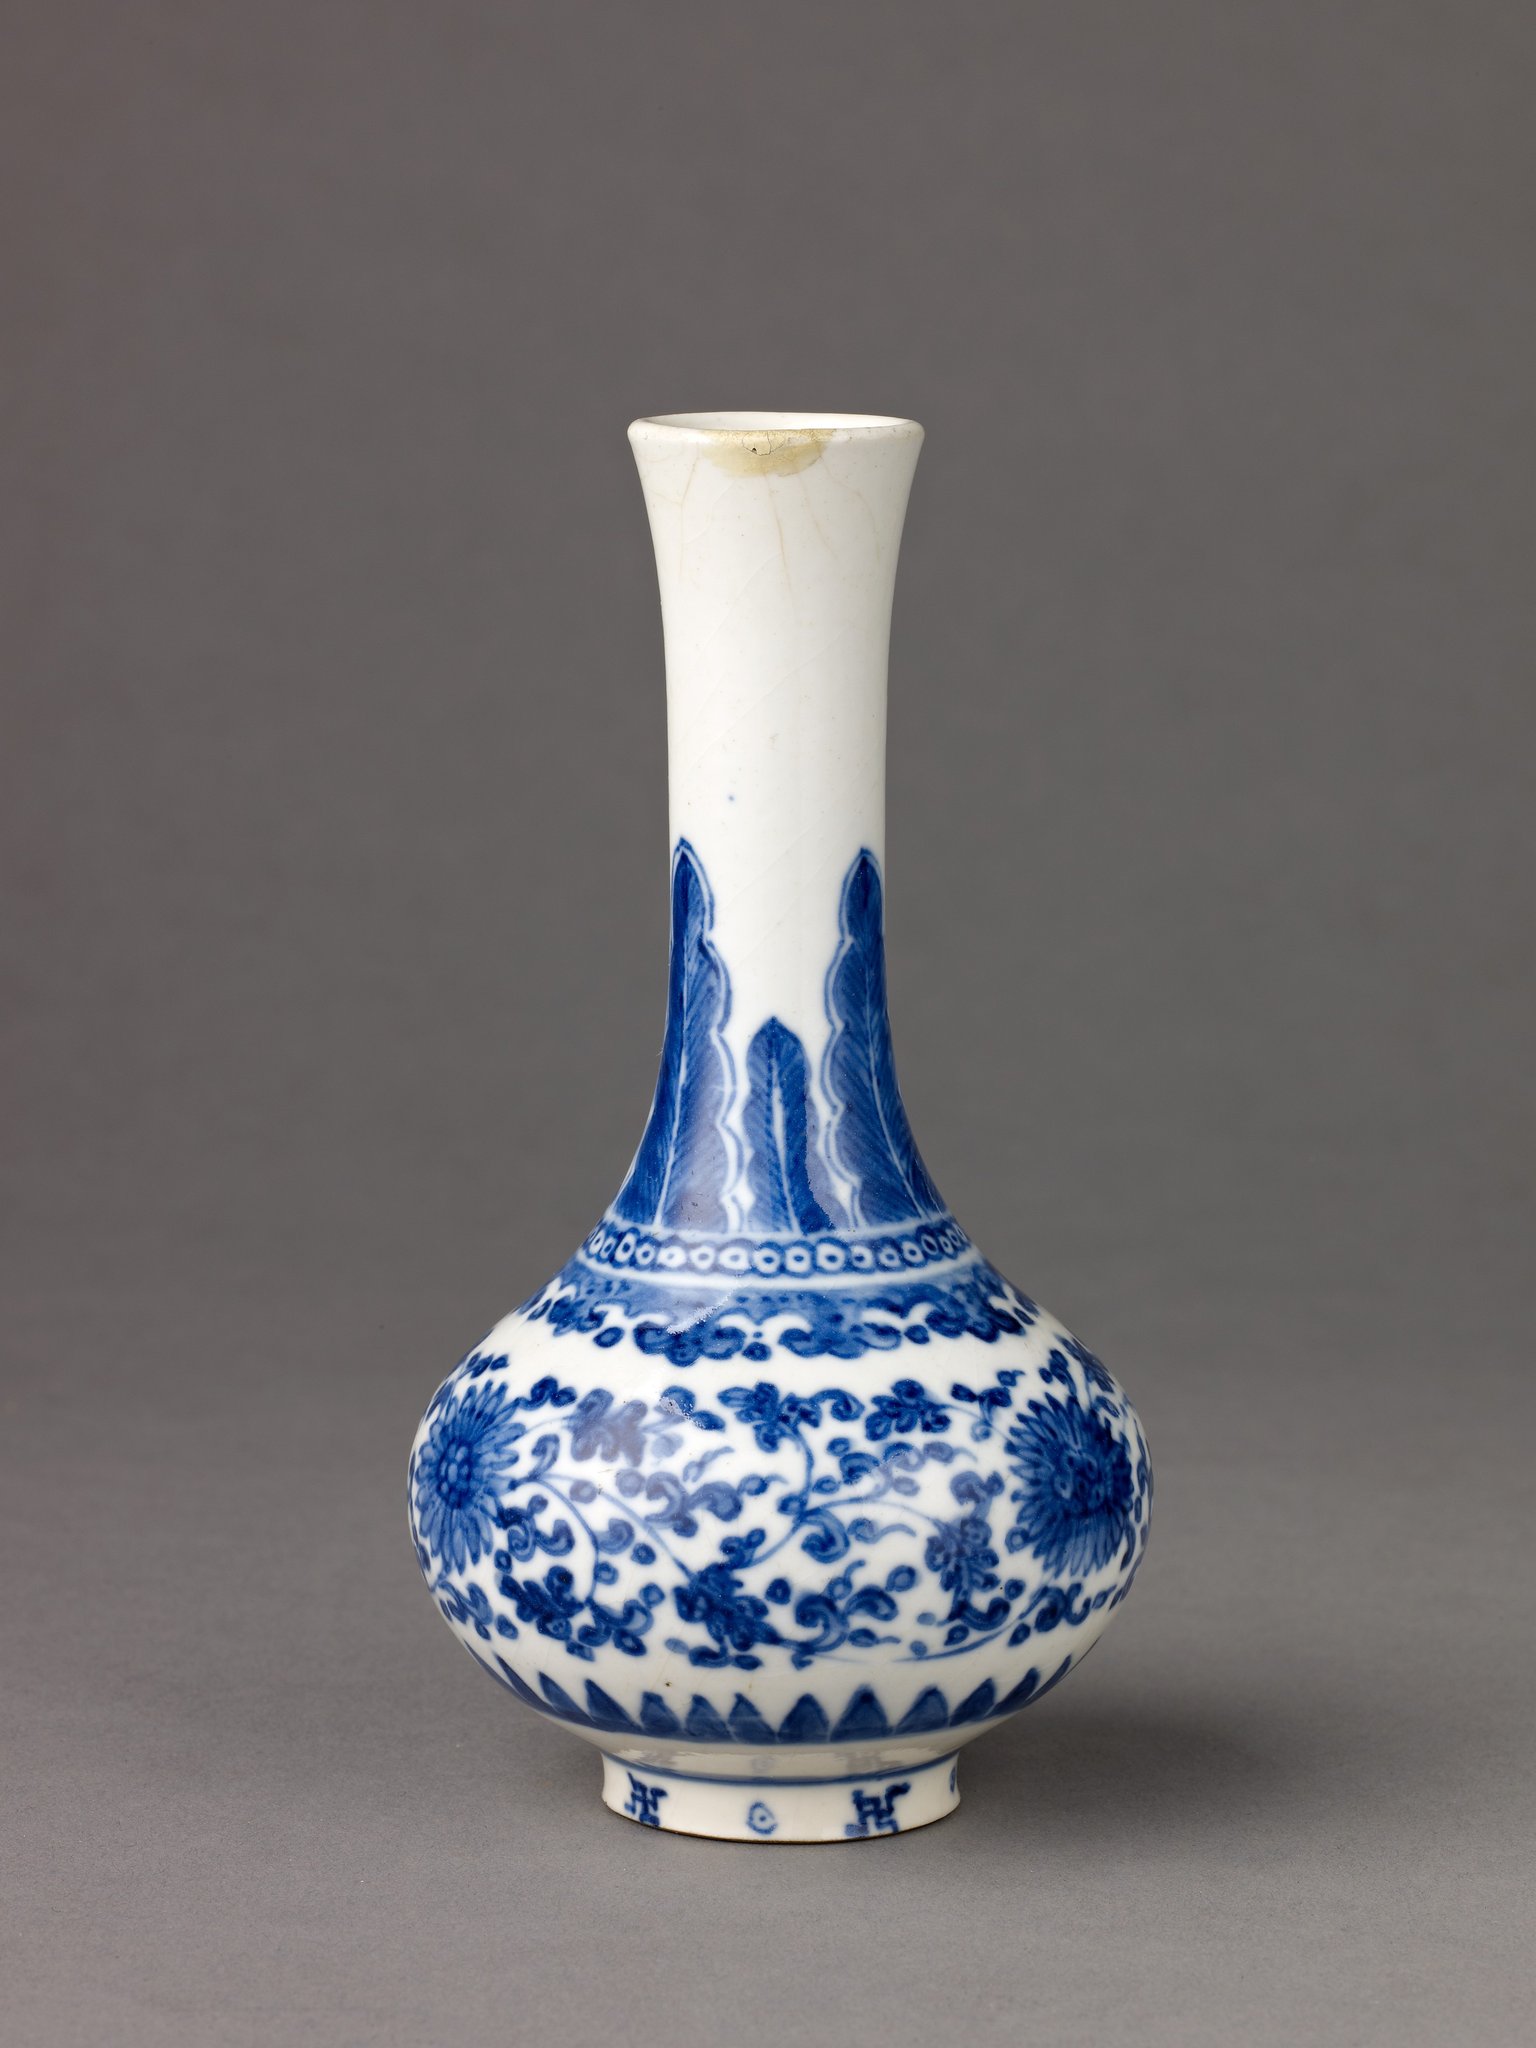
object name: vase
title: Small vase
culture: chinese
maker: chinese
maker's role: artist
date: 1767-1800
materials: porcelain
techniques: painting, underglaze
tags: flowers